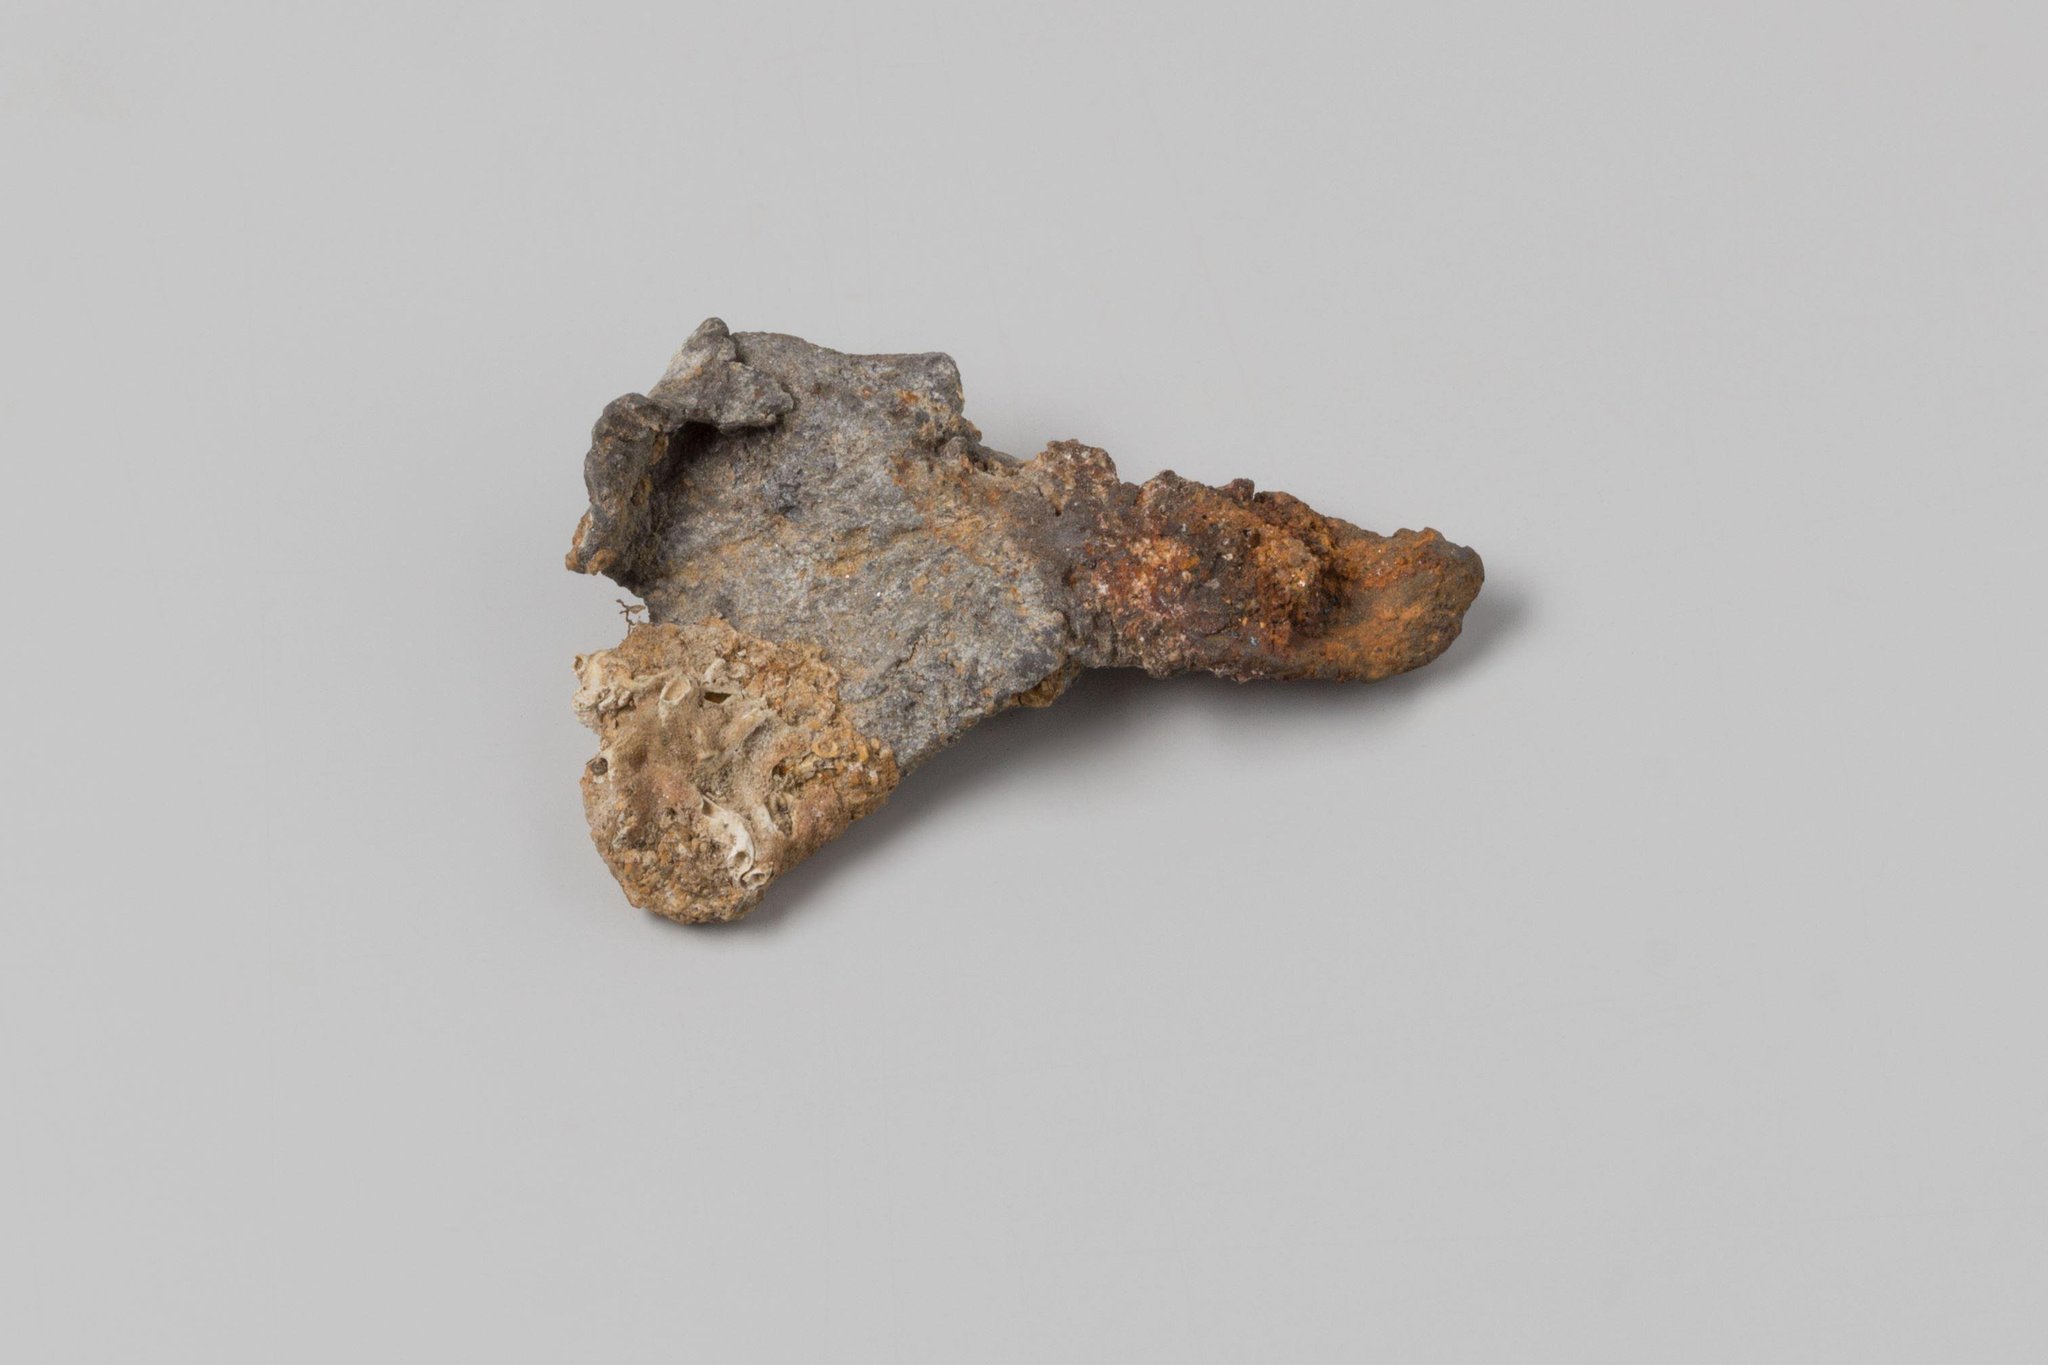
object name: scheepswrakvondst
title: Scheepswrakvondst uit het wrak van de Oost-Indiëvaarder Hollandia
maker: Anonymous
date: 1700-1743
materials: lead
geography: netherlands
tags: verenigde oostindische compagnie, hollandia (schip), annet